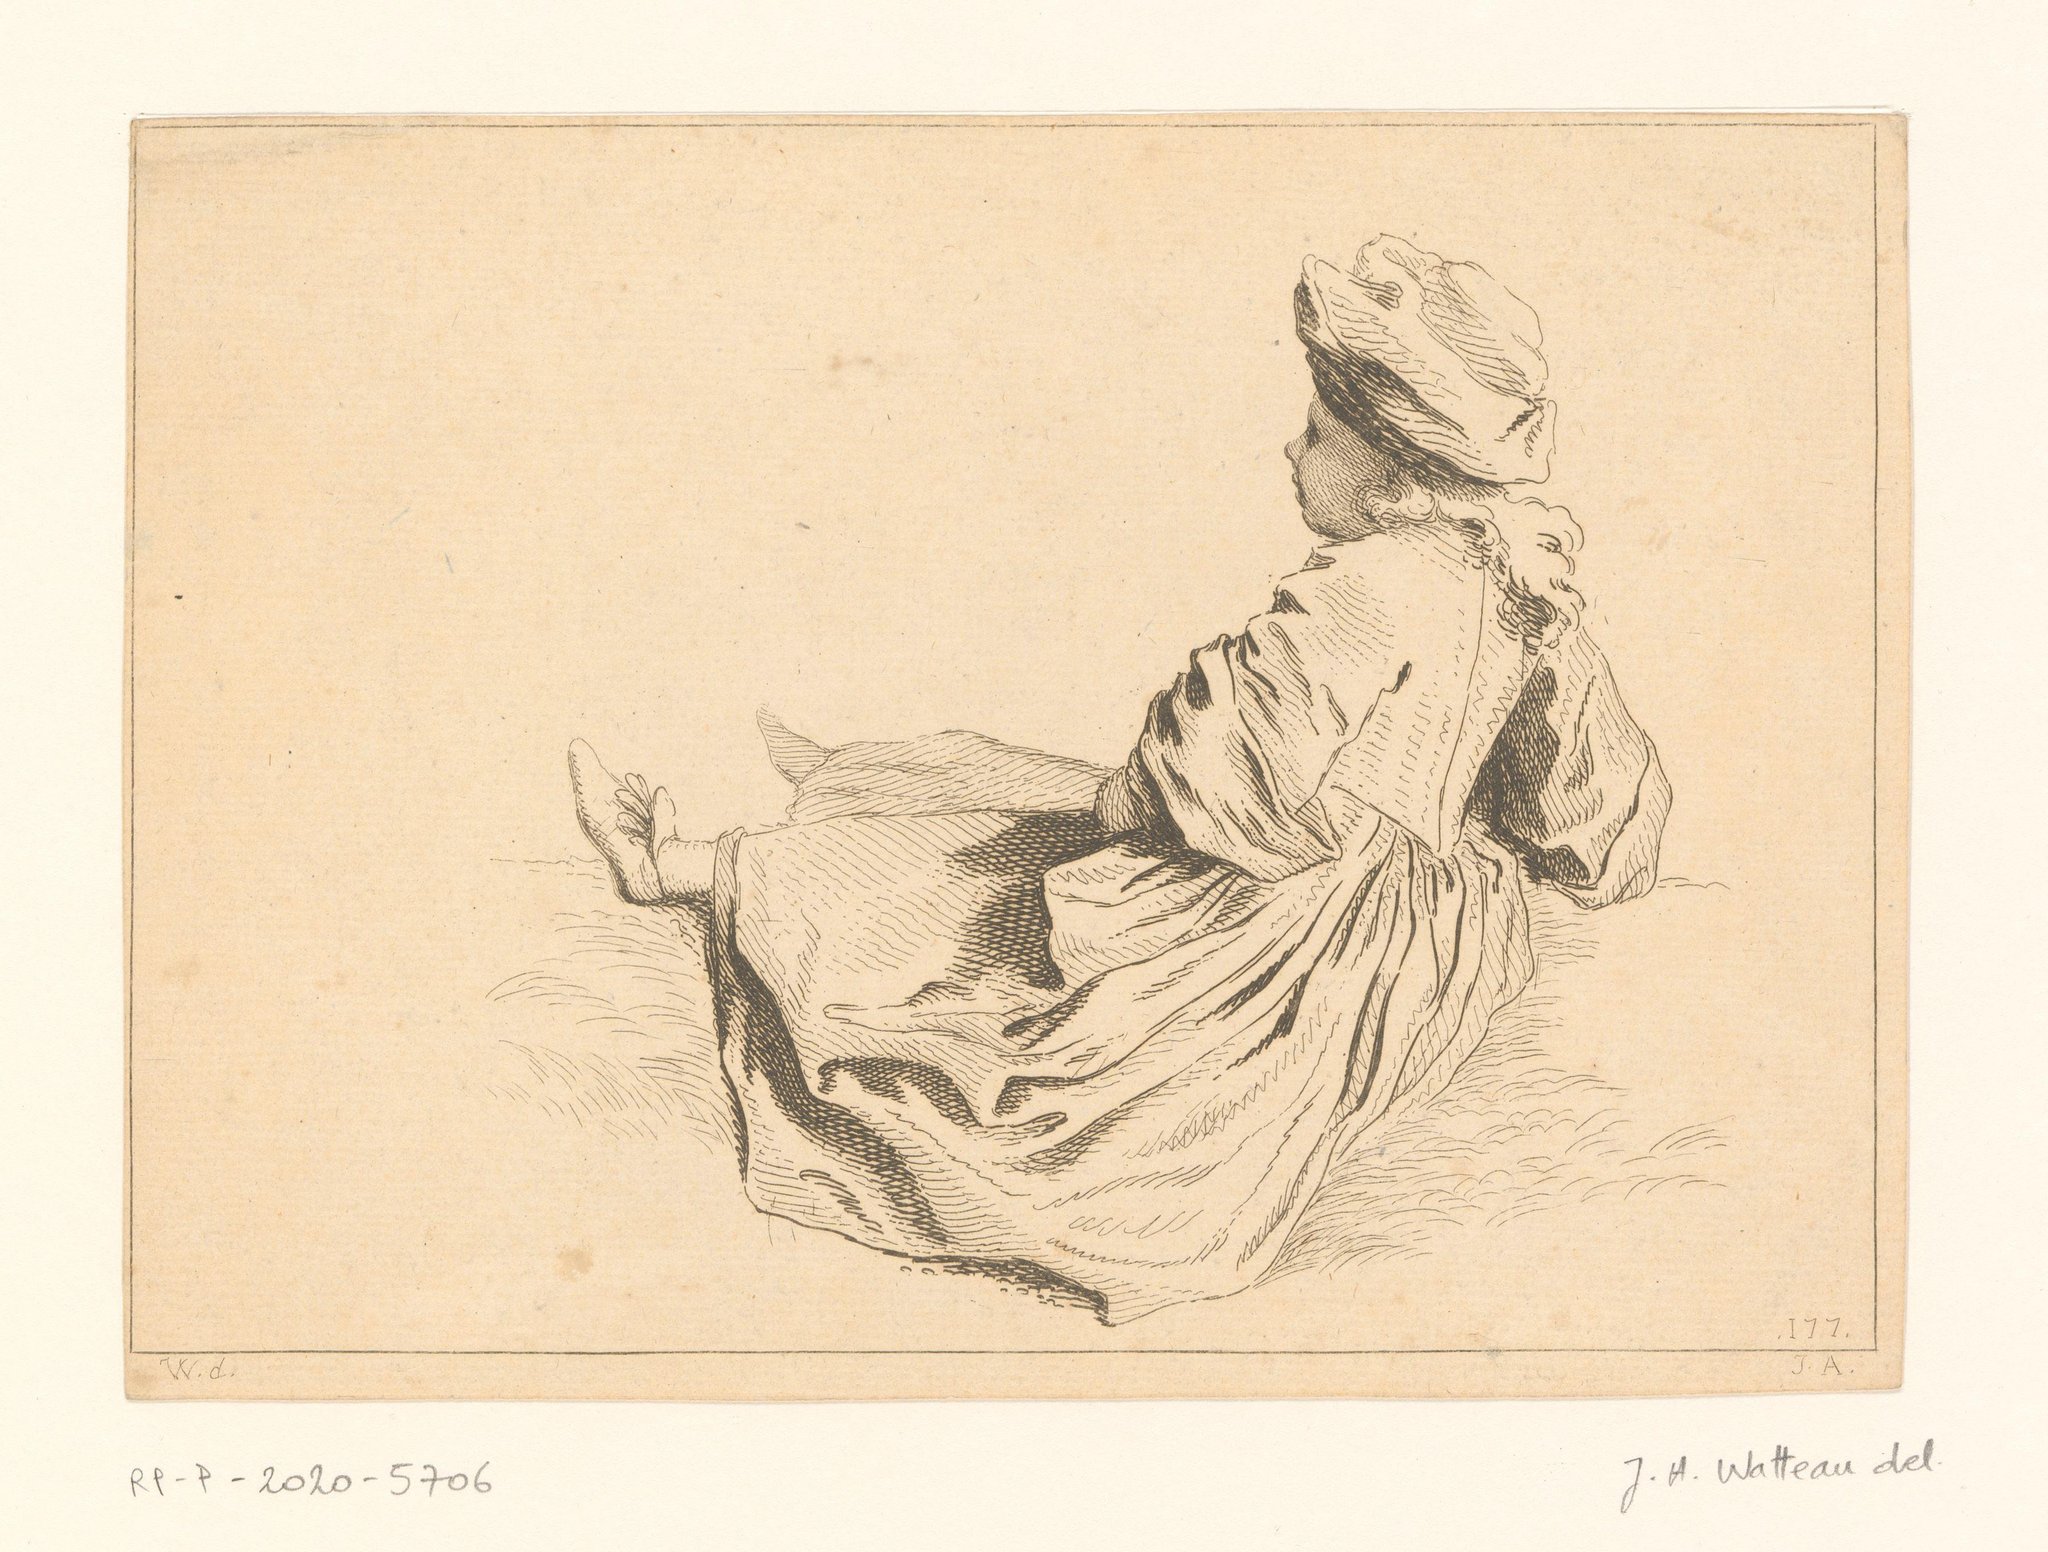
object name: print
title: Figures de différents caractères, de Paysages, et d'Etudes dessinées d'après nature par Antoine Watteau (...)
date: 1728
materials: paper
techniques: etching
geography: france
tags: child, head-gear: hat, sitting on the ground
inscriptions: collector's mark: Lugt 533b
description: Prent is in 1728 gebruikt voor het tweede deel van 'Figures de différents caractères, de Paysages, et d'Etudes dessinées d'après nature par Antoine Watteau (...)', een project waar vijftien prentmakers aan meewerkten. De platen werden gedrukt door Jean de Julienne. Het eerste deel bevat de nummers 1 t/m 132 en werd in 1726 geadverteerd in de Mercure. Het tweede deel bevat 133 t/m 350 en werd in 1728 geadverteerd. In 1739 werden de platen verkocht aan Chereau, waarna ze in handen kwamen van Huquier. Deze zette zijn adres op de platen.